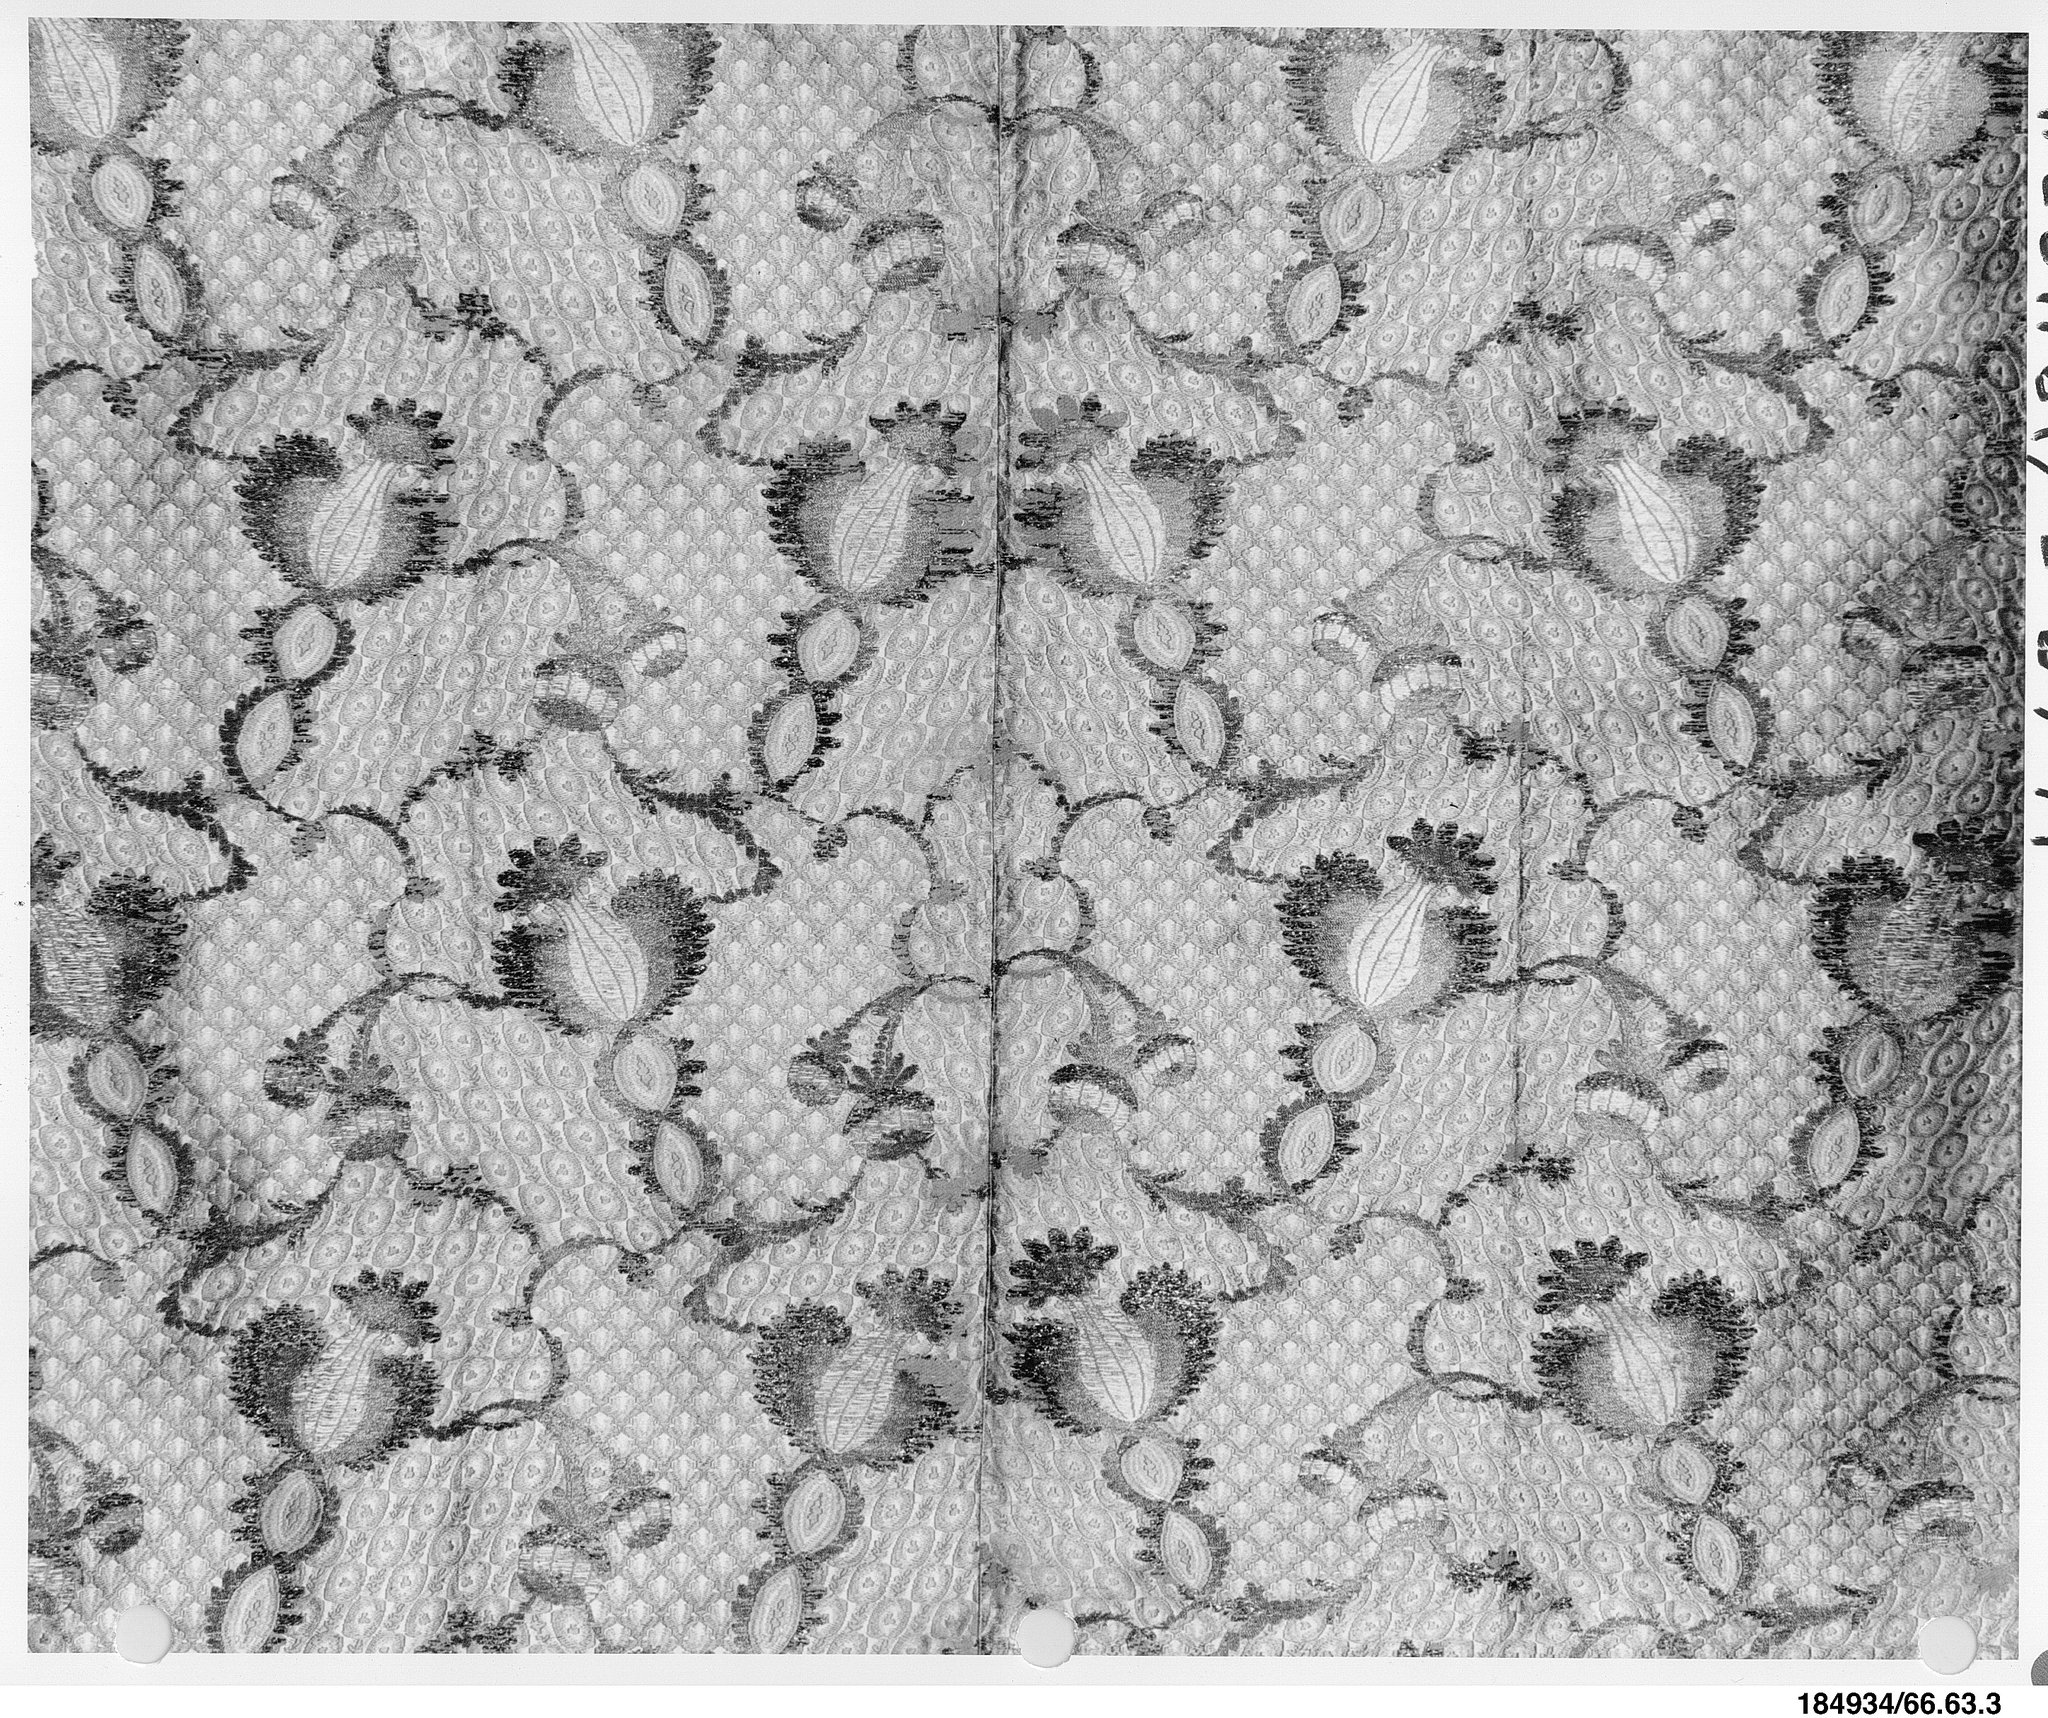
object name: piece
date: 1701-1733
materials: metal thread, silk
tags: flowers